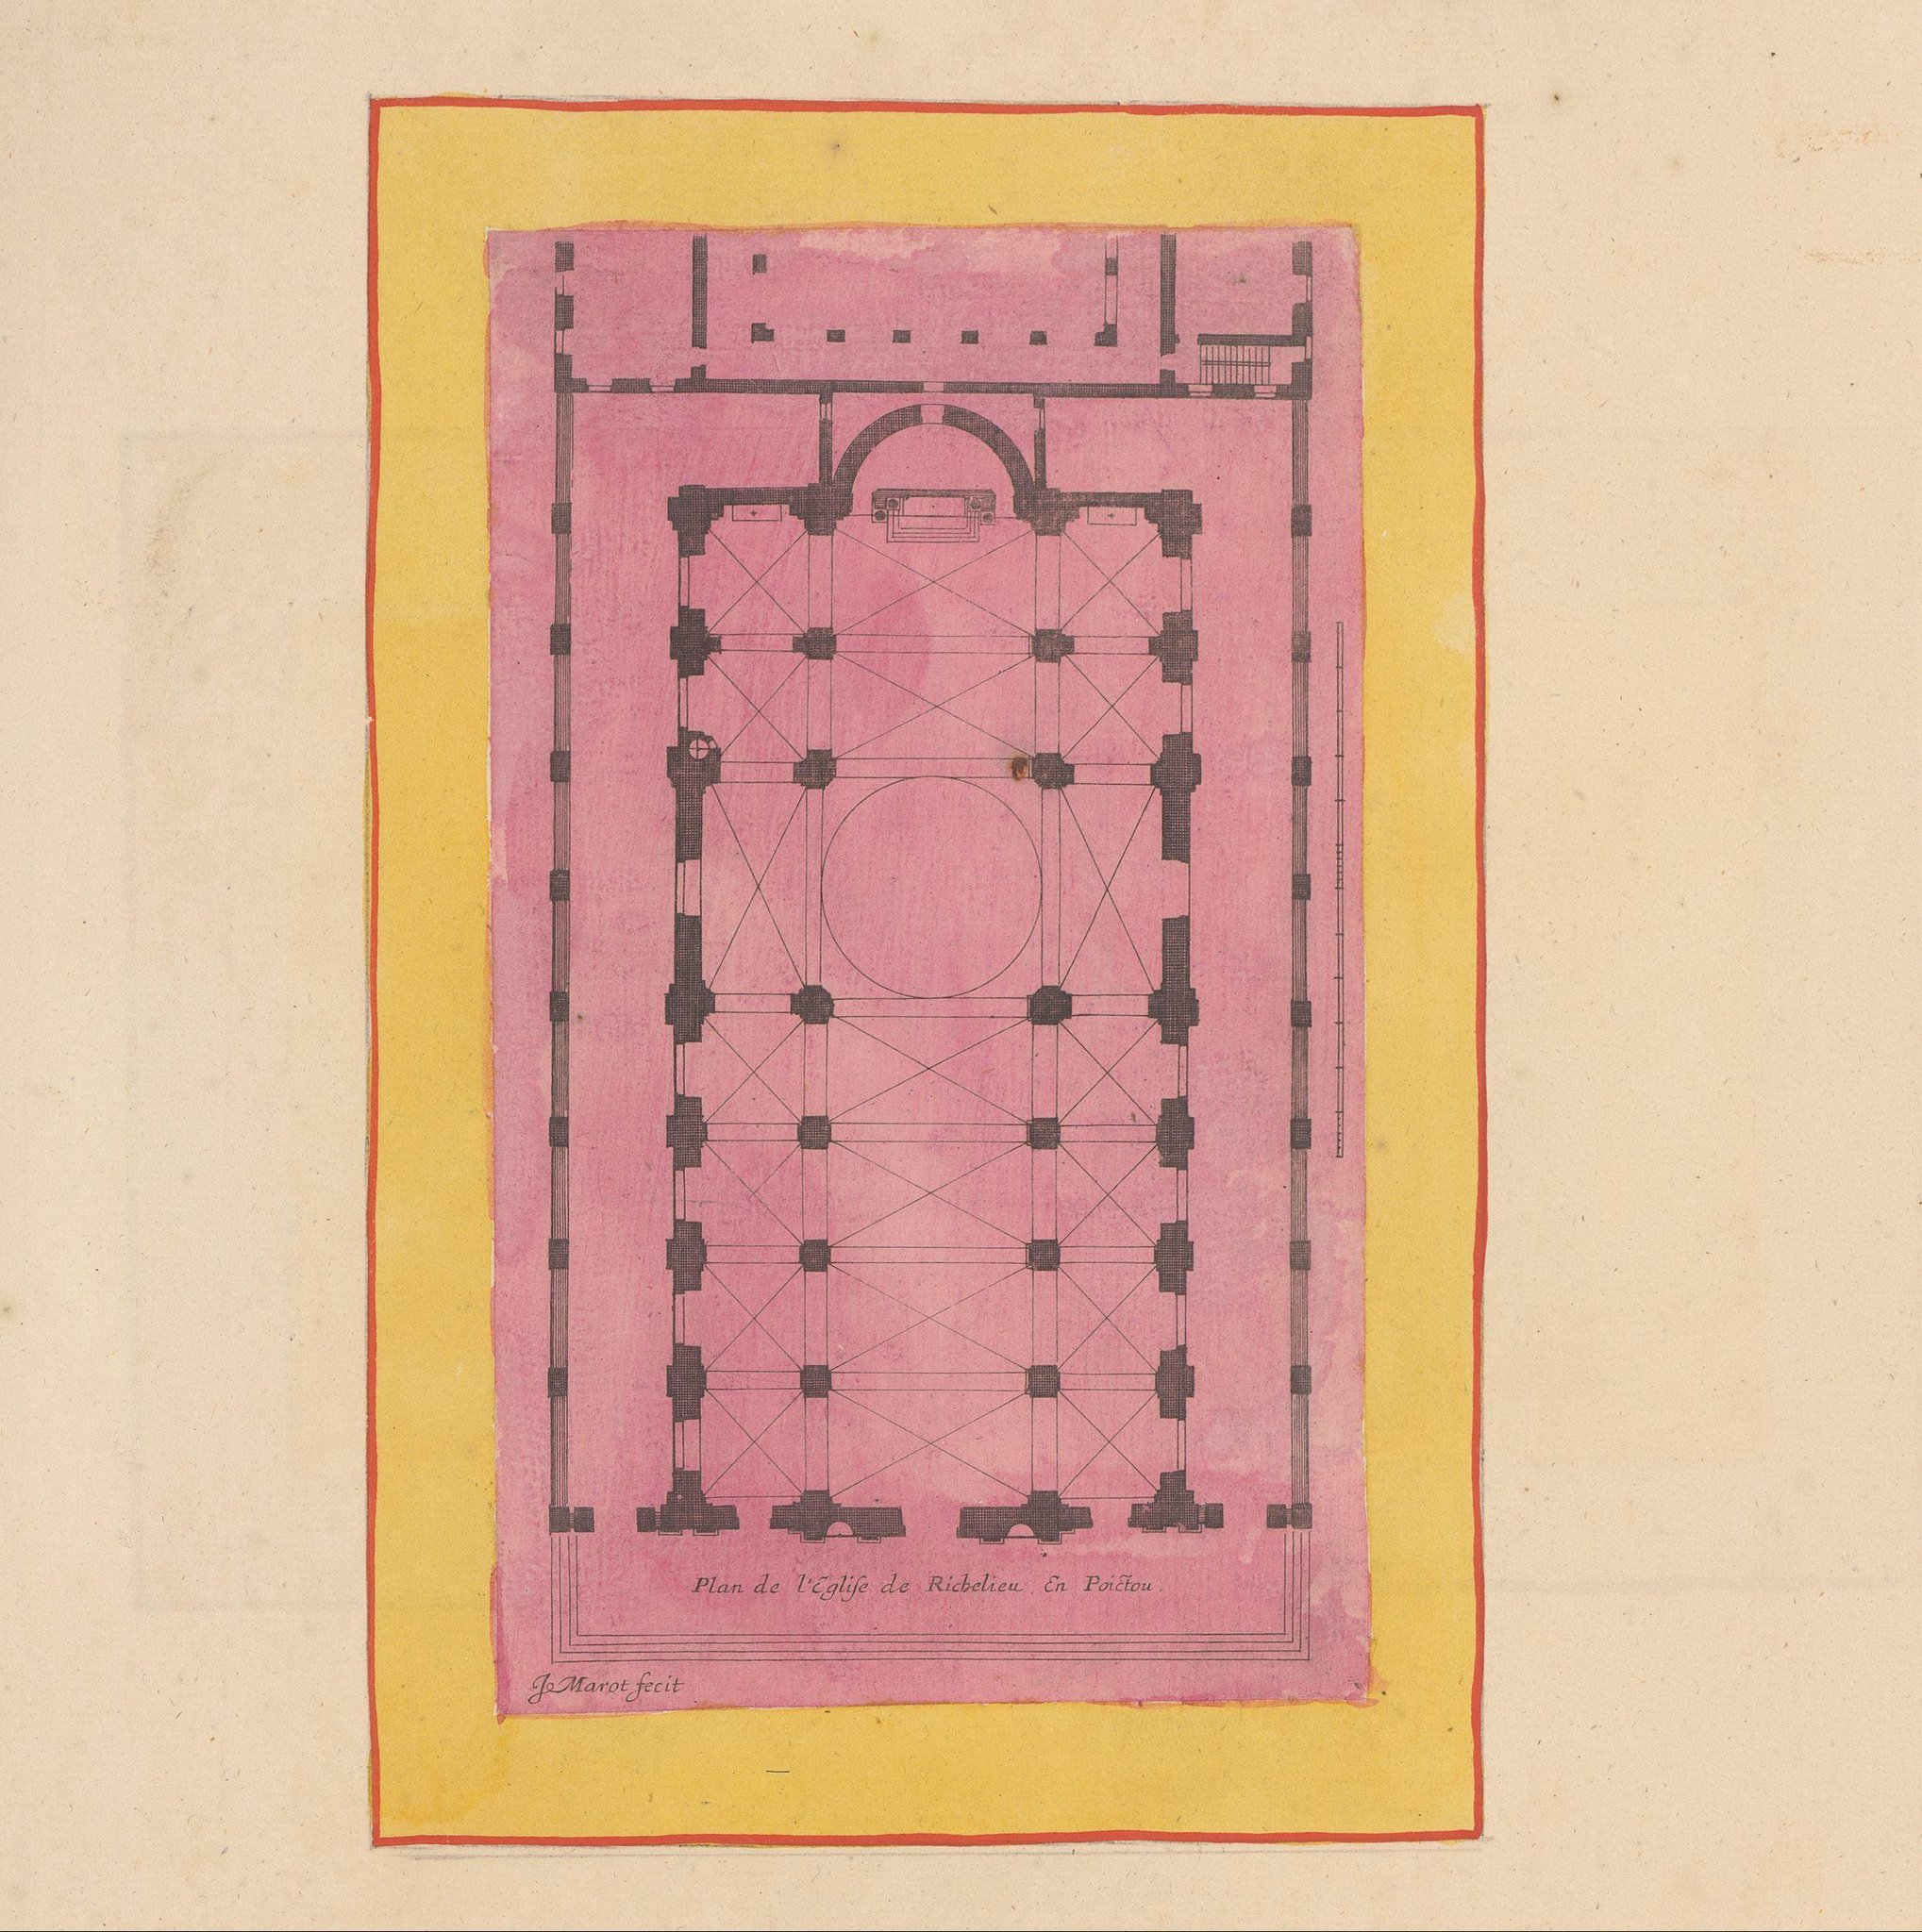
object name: print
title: Kasteel van Richelieu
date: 1629-1679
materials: paper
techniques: etching, hand coloring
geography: the hague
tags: interior of church, plan ~ architecture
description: Deze prent maakt deel uit van een album.